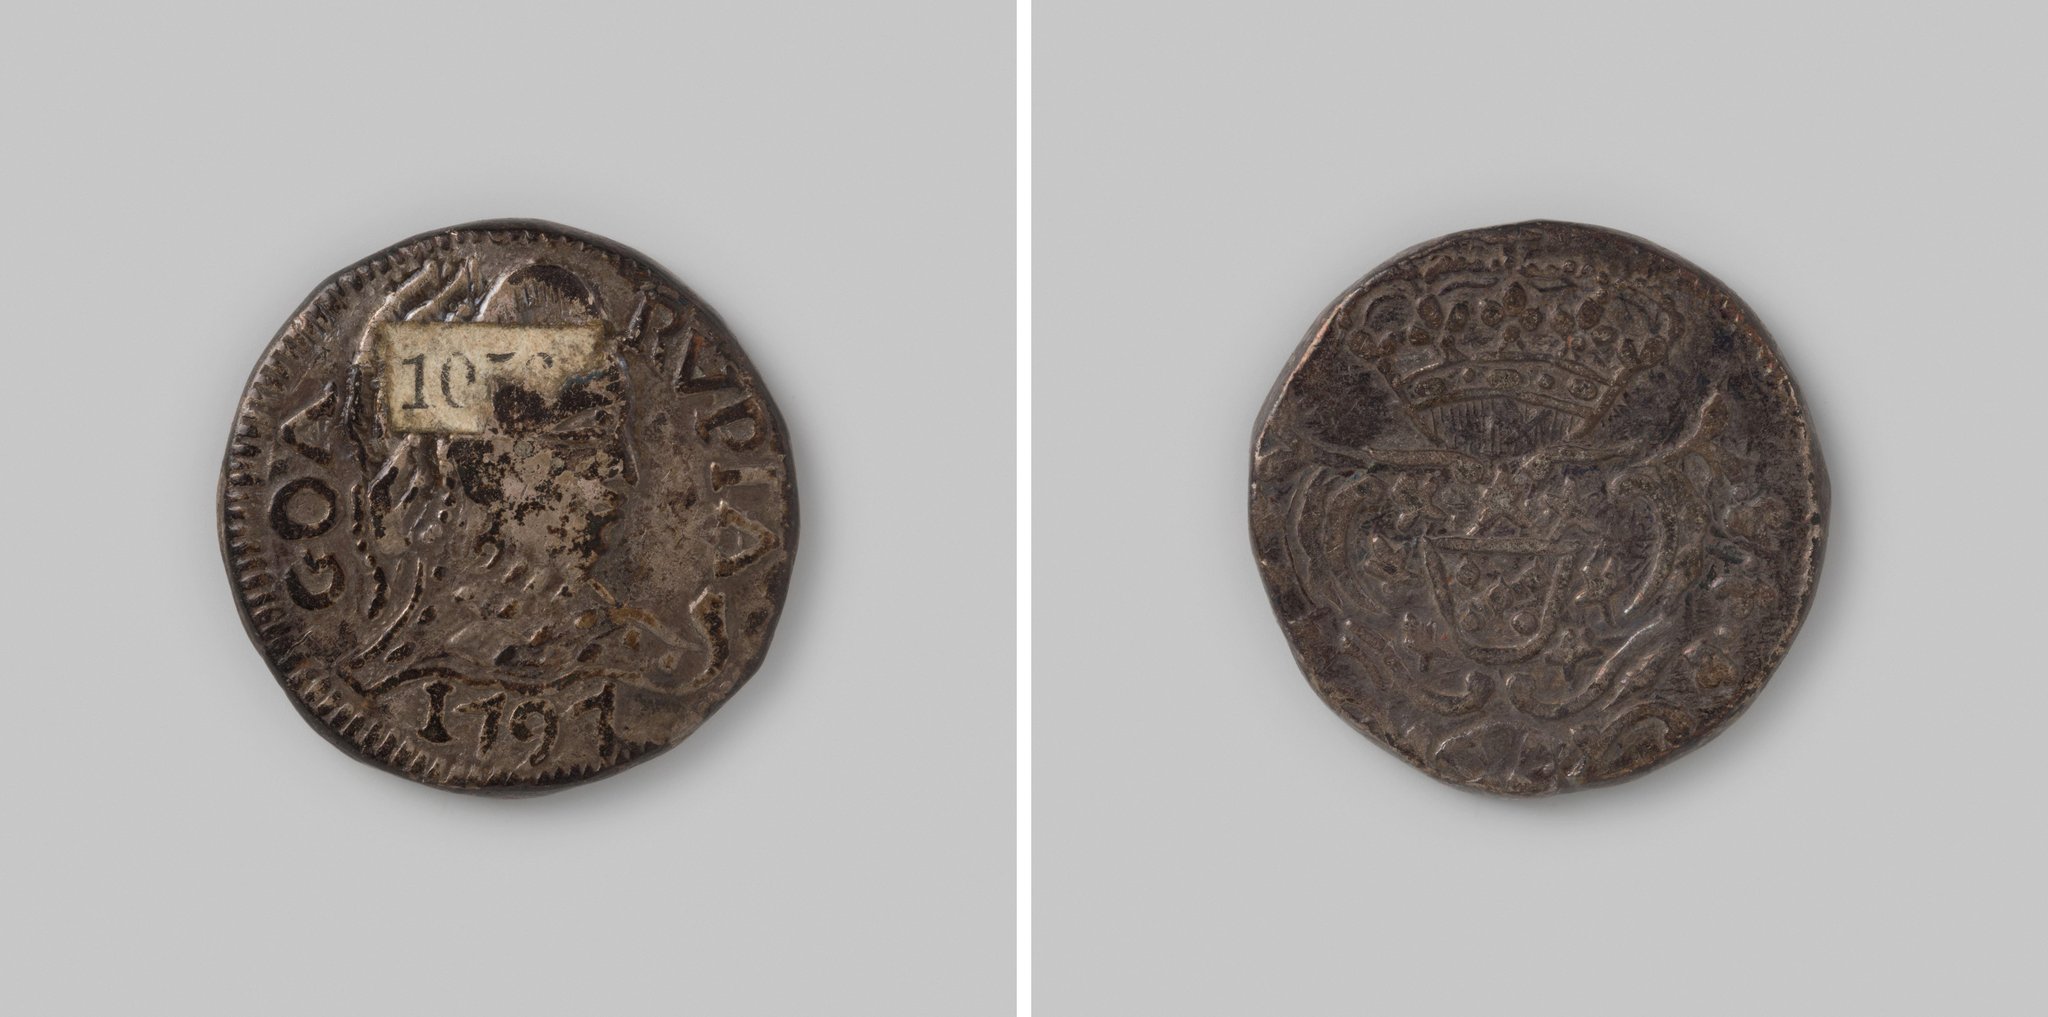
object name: coin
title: Rupia of 2 pardaos uit Goa, Portugees India van koningin Maria I, 1797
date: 1797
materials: silver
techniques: striking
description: Zilveren munt. Voorzijde: hoofd naar rechts. Daaronder jaartal. Waarde-aanduiding: rvpia in omschrift, Keerzijde: gekroond versierd wapenschild van Portugal. Gladde rand.